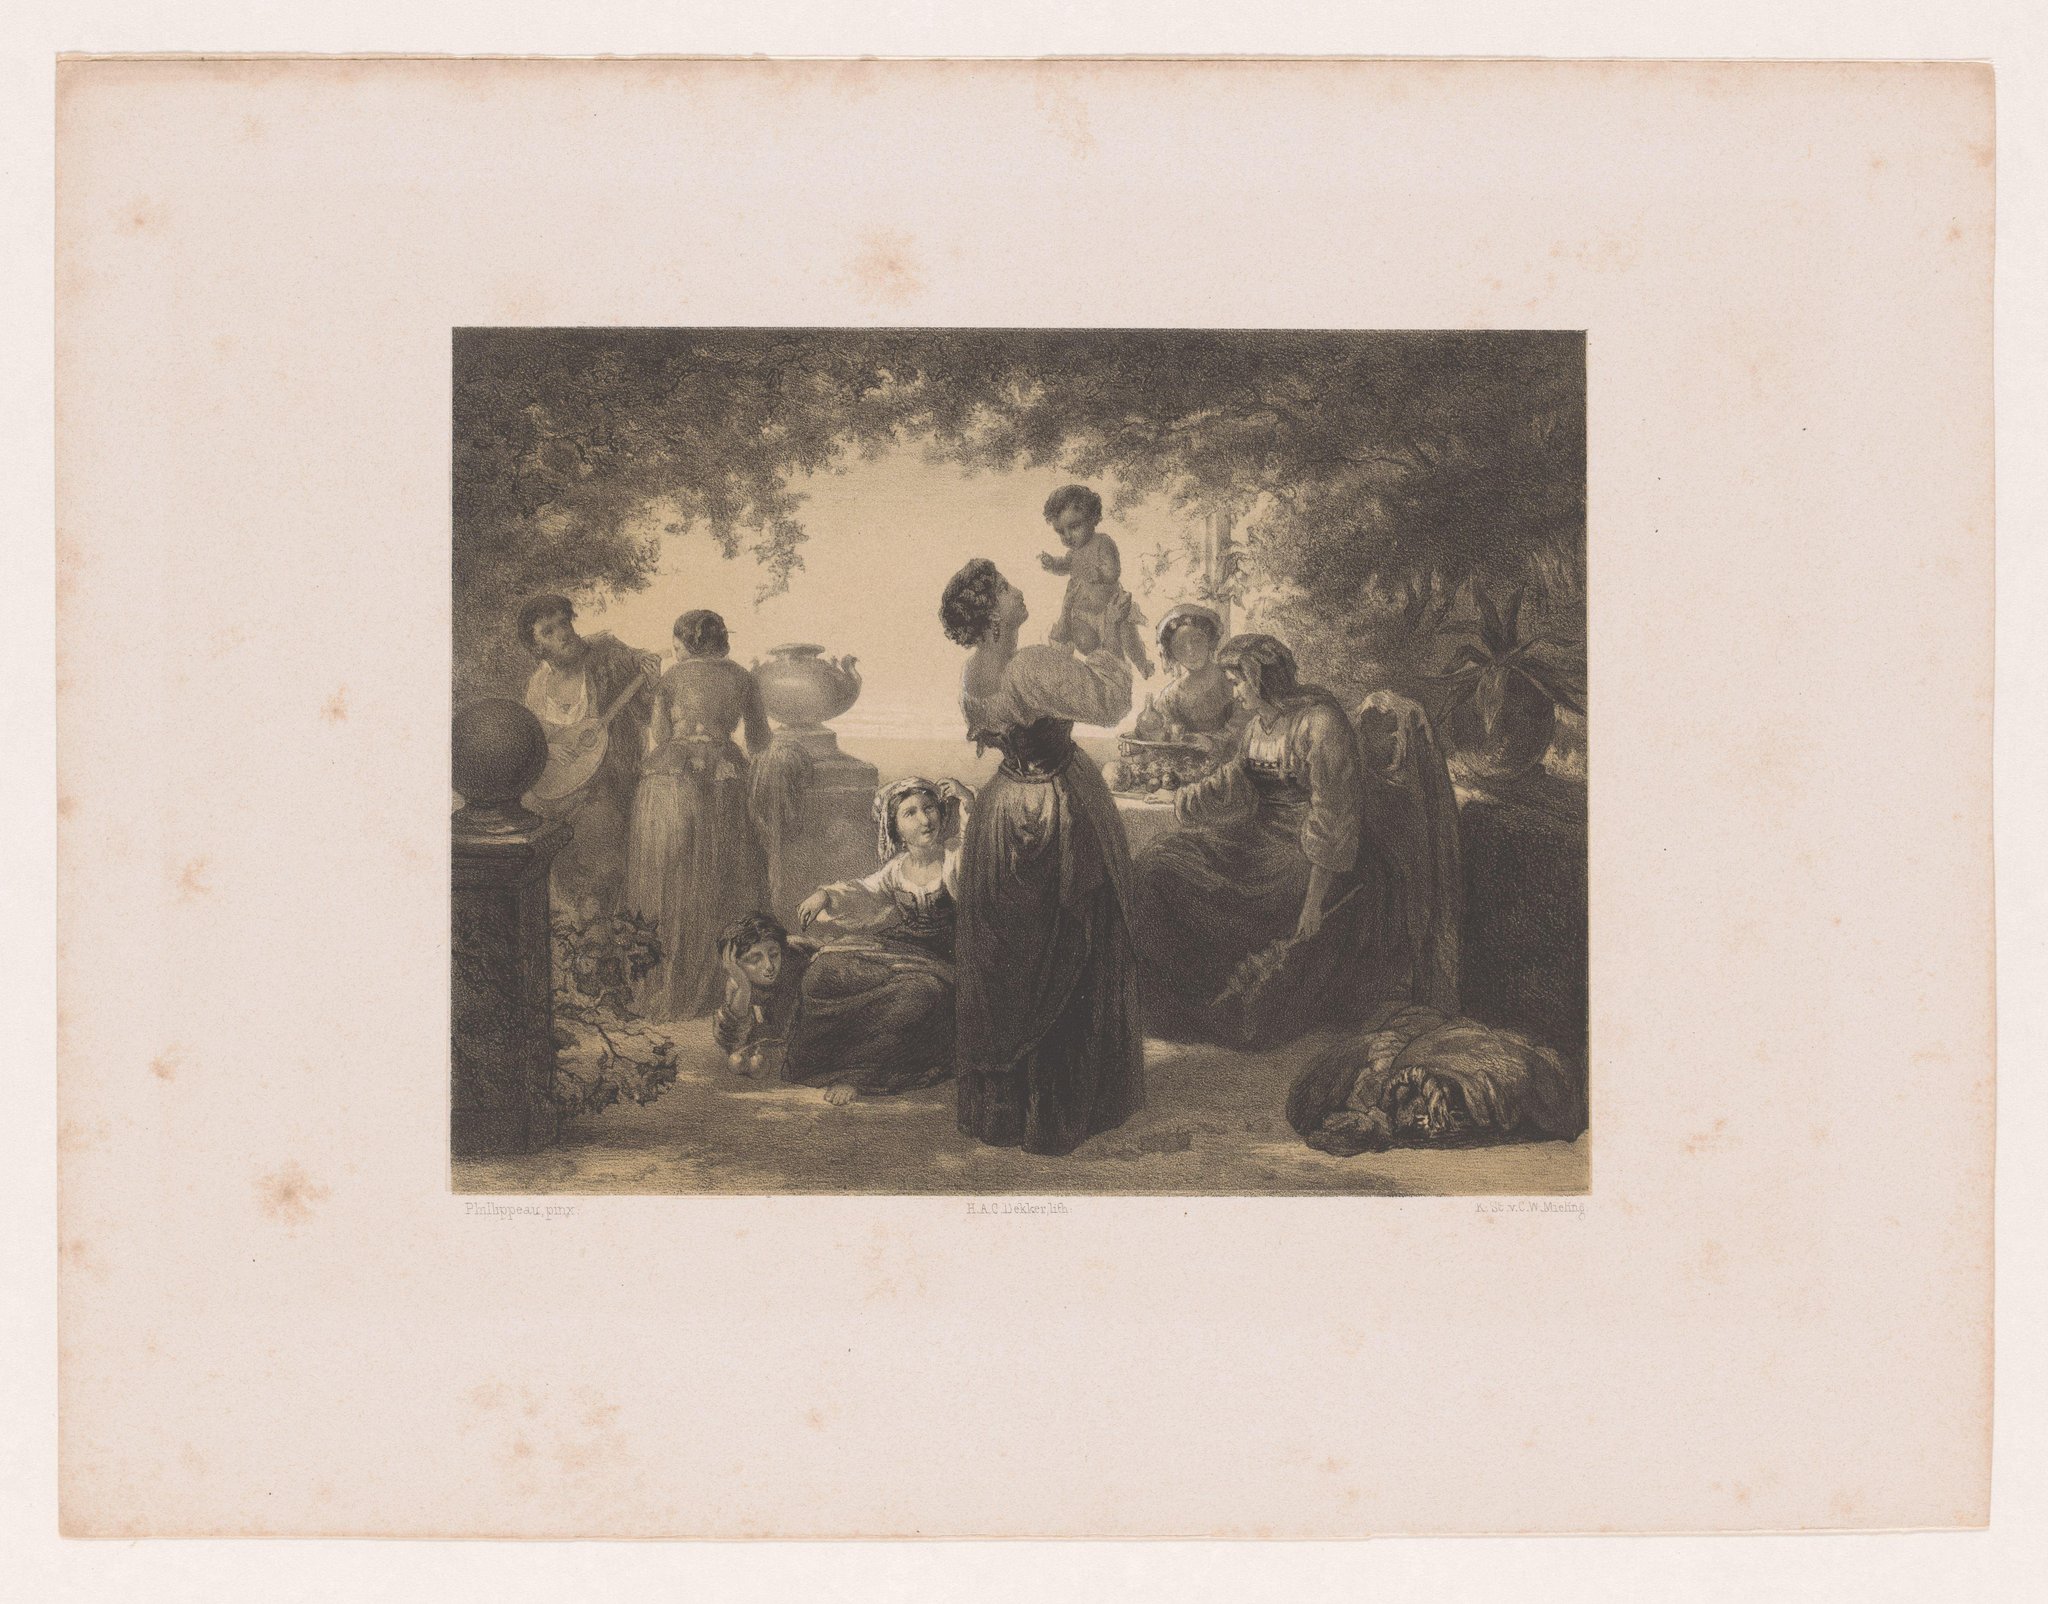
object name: print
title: Italiaanse vrouwen bij een tafel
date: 1846-1892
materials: paper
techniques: tone lithography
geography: the hague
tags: europeans, midday meal, lunch - cc - out of doors, cithern, mandolin, guitar, balalaika - cc - out of doors, infant, baby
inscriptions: collector's mark: Lugt 2228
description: Het gezelschap bevindt zich buiten tussen bomen. Links staat een man die een mandoline bespeelt. In het midden staat een vrouw die een kind omhoog tilt.